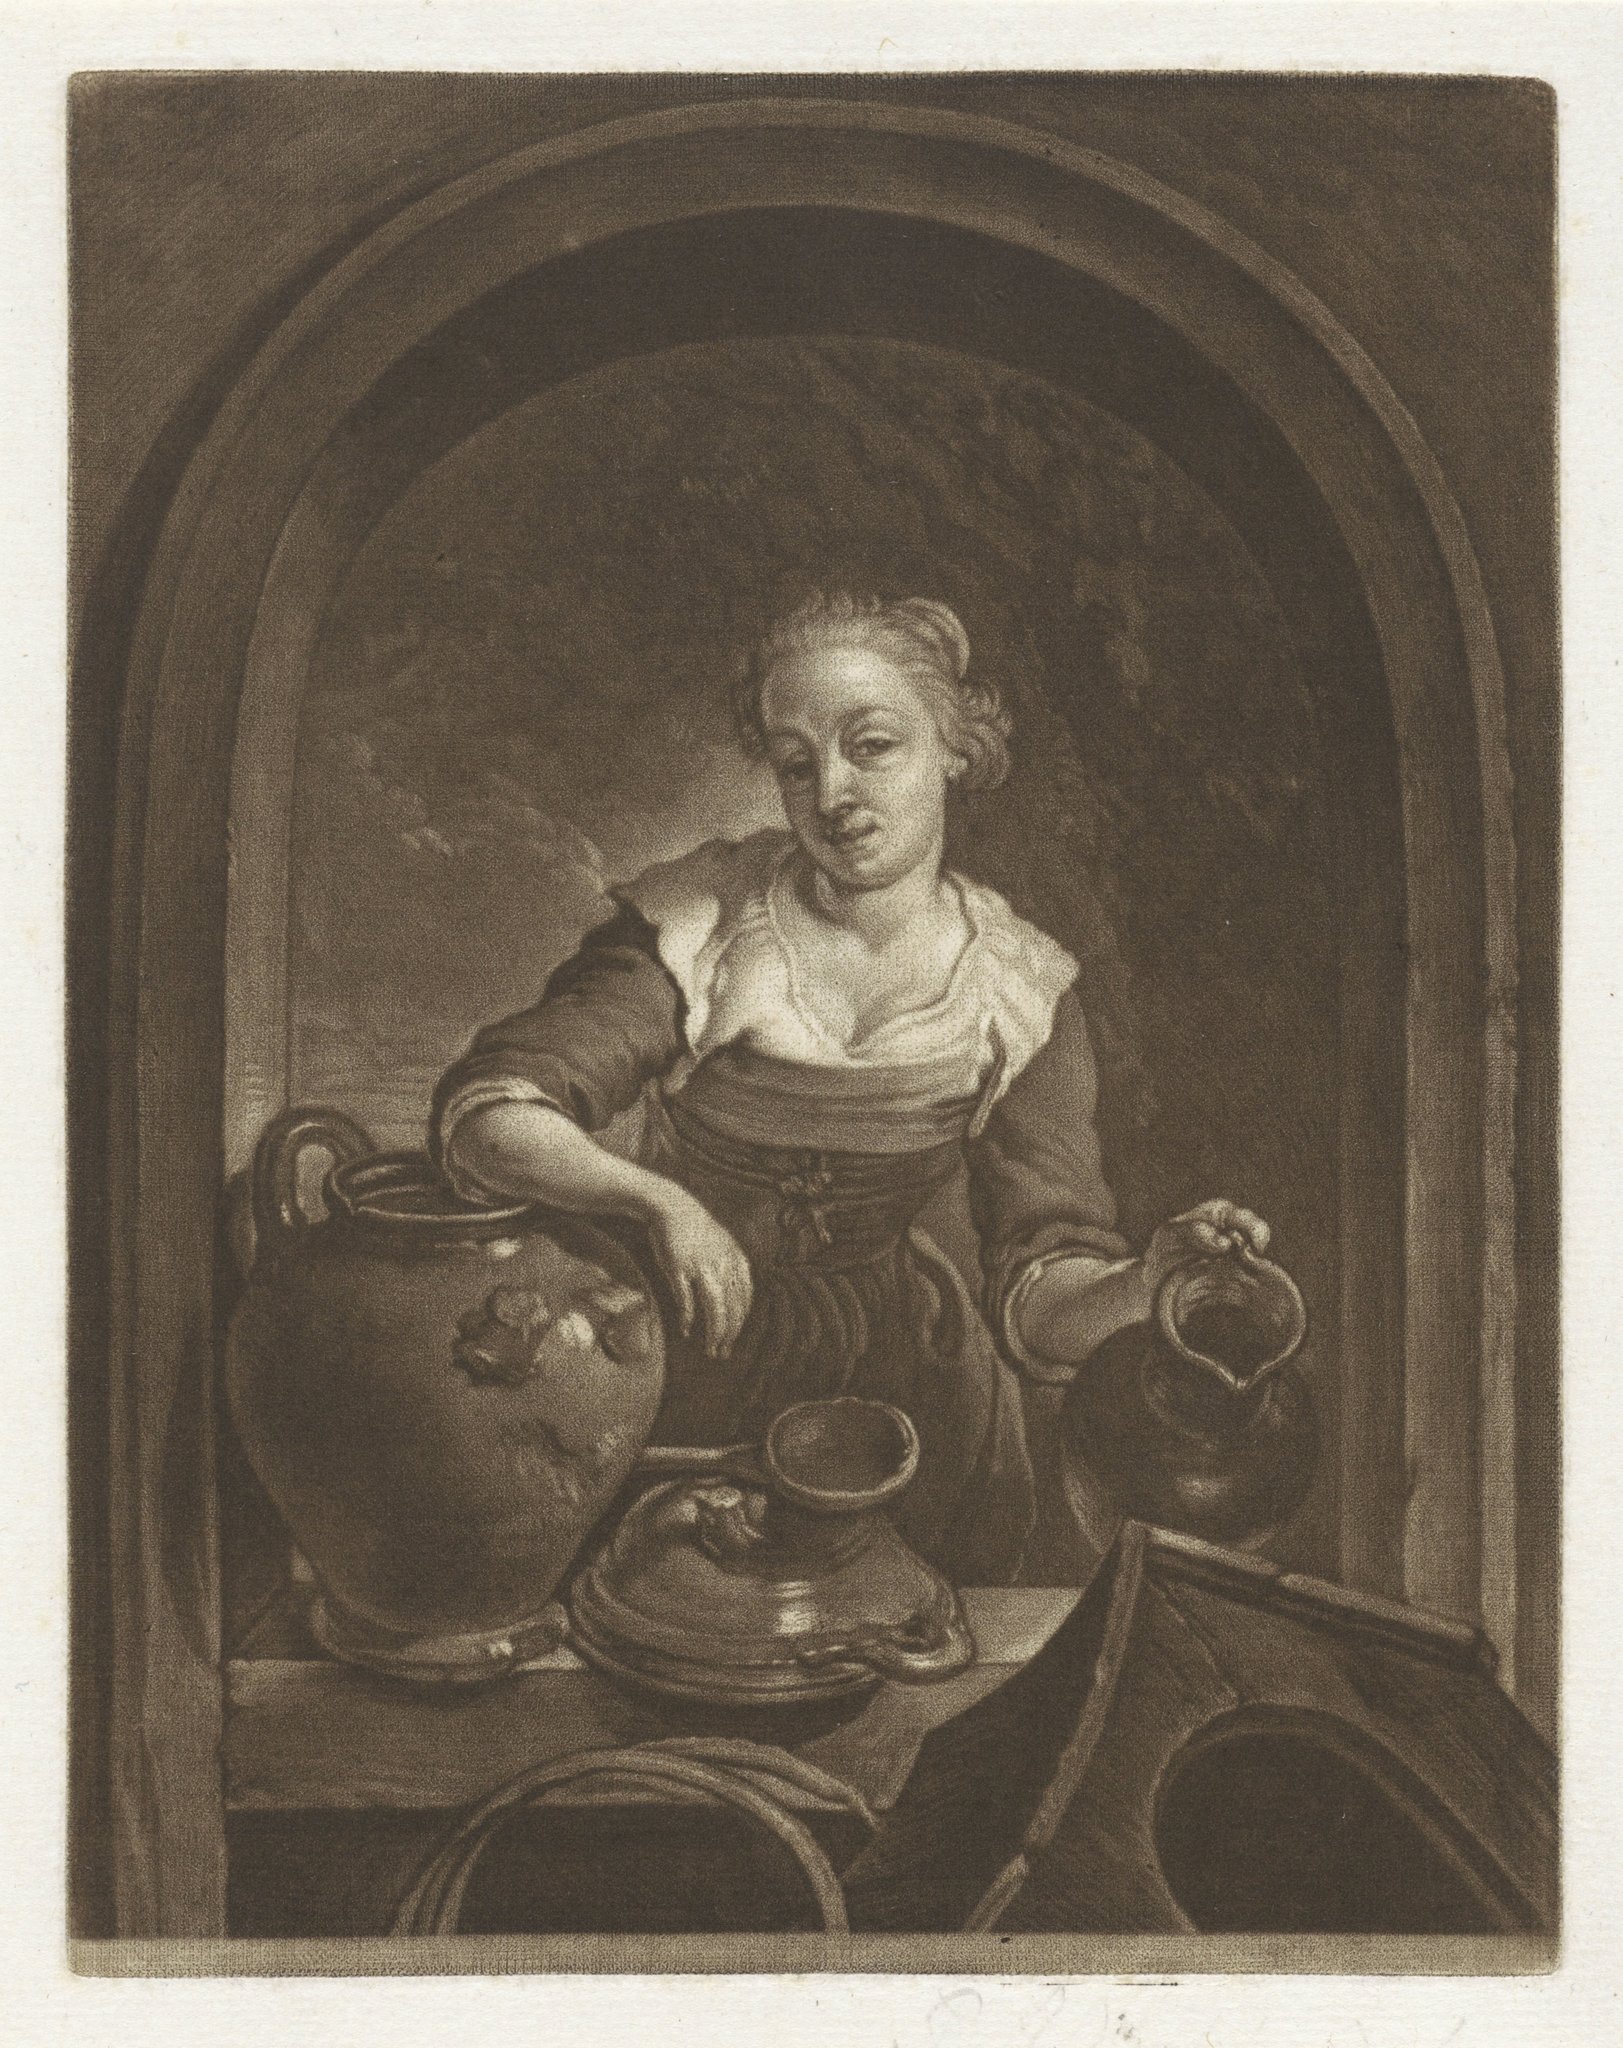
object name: print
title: Jonge vrouw met een kruik in een venster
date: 1740-1774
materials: paper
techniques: print in brown, mezzotint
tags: human figure at (open) window, seen from outside - aa - feigned window, container of ceramics: jar, jug, pot, vase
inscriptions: collector's mark: Lugt 240